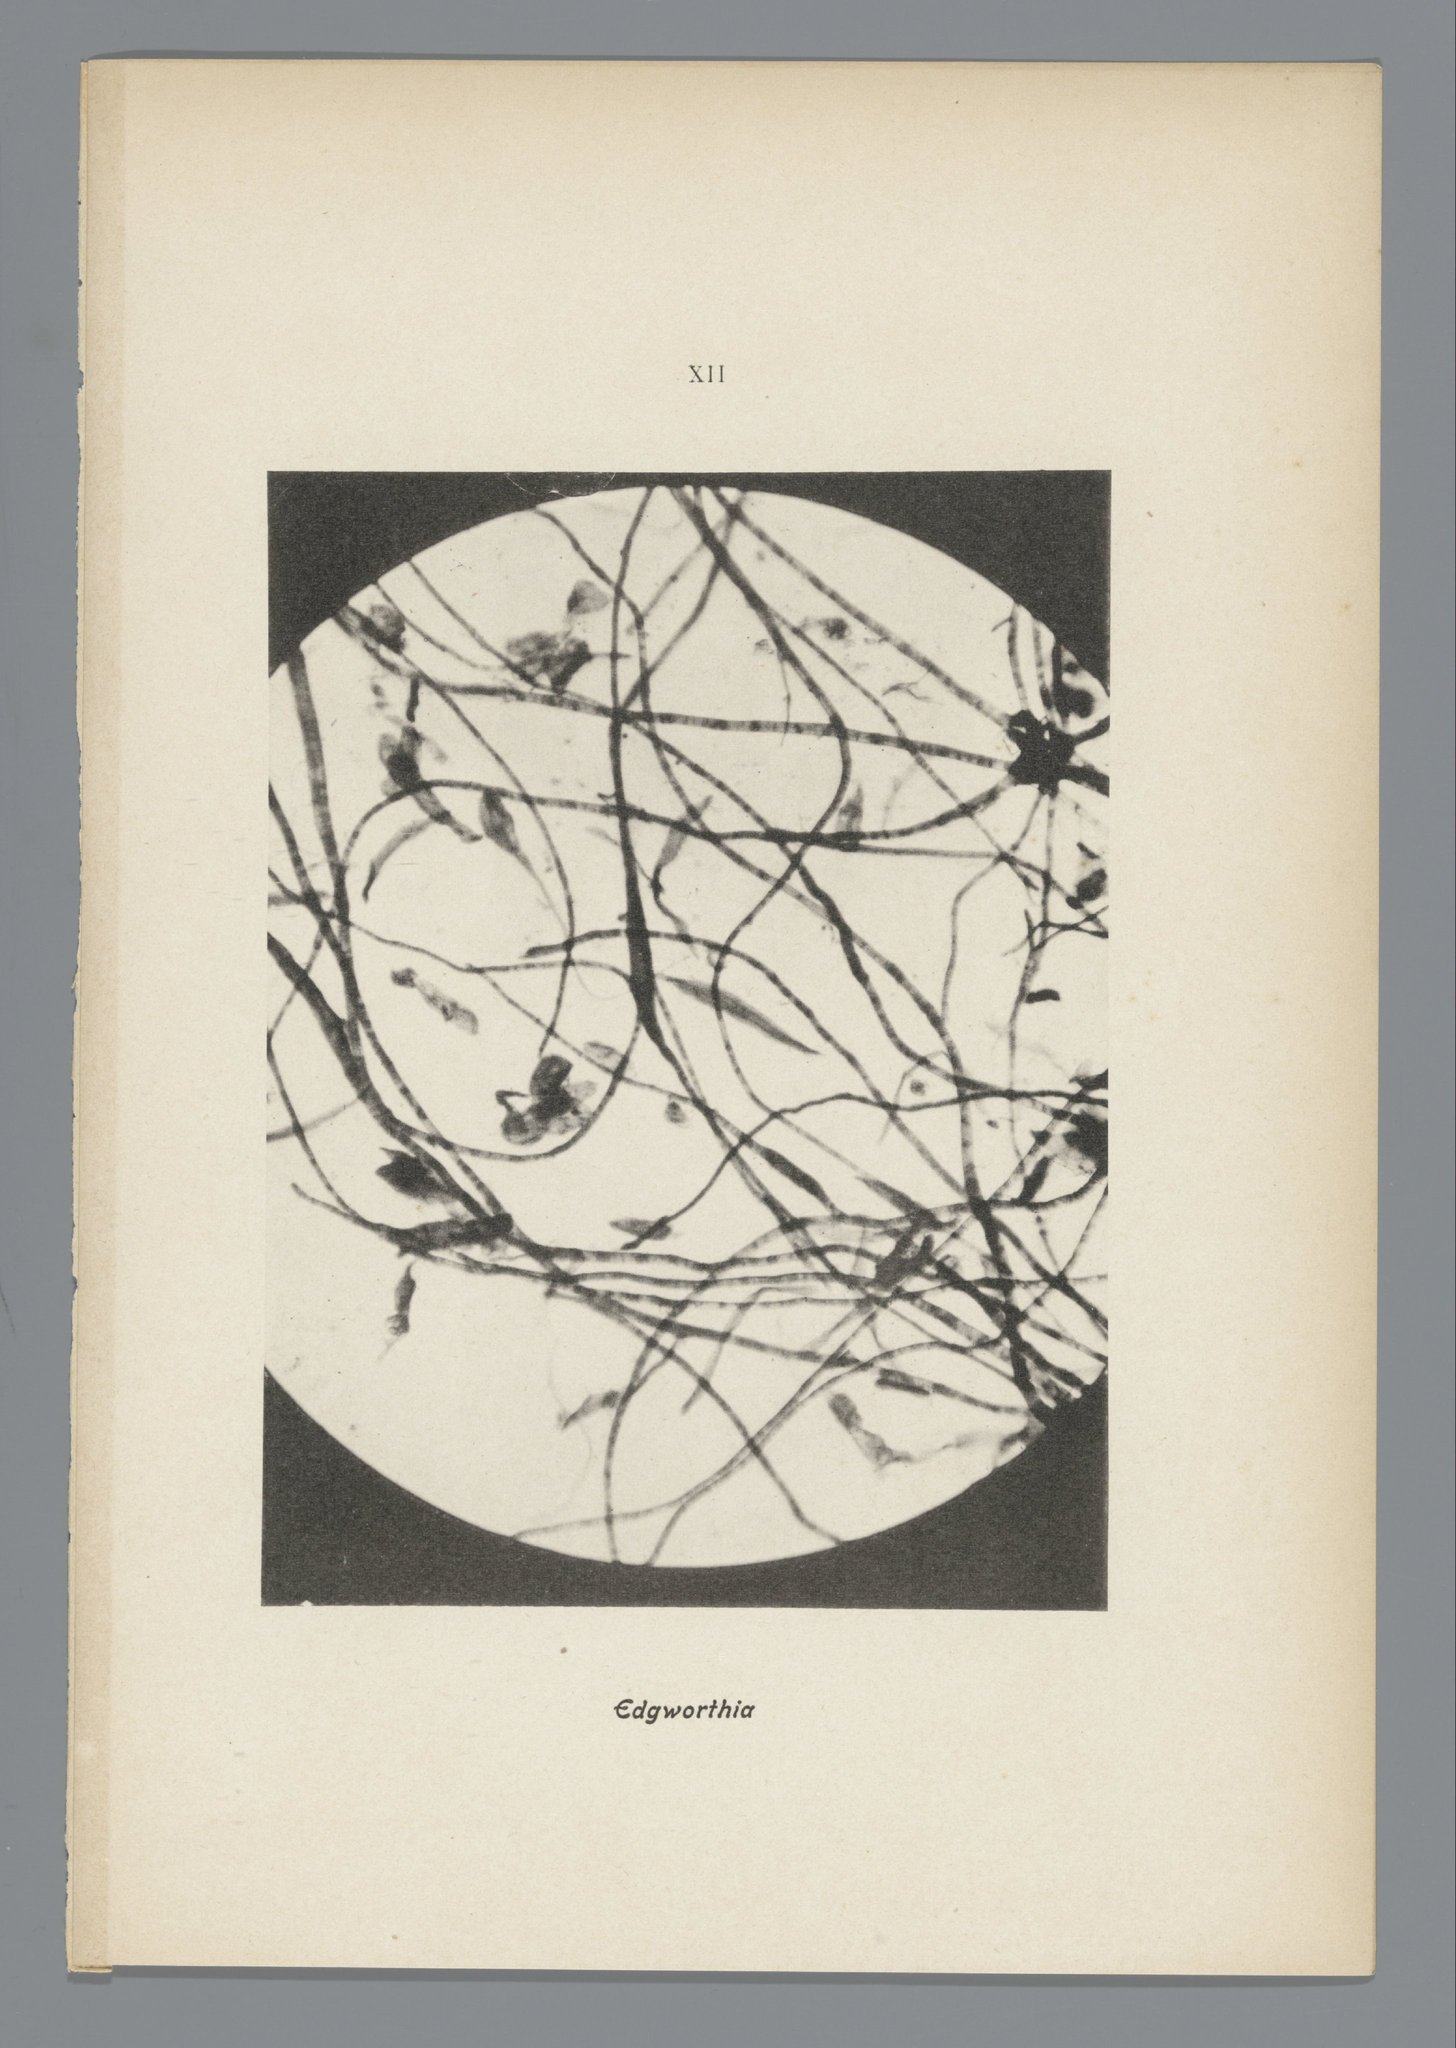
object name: photograph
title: Photomicrographs of Paper Fibres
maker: Anonymous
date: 1900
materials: ink, paper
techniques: photograph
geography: france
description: For science, photography was a useful tool for supplementing or refuting what could be observed with the human eye. The camera, after all, saw more than the eye, and the photographic plate had a better ‘memory’ than man. By combining a microscope and a camera, tiny objects could also be studied closely.